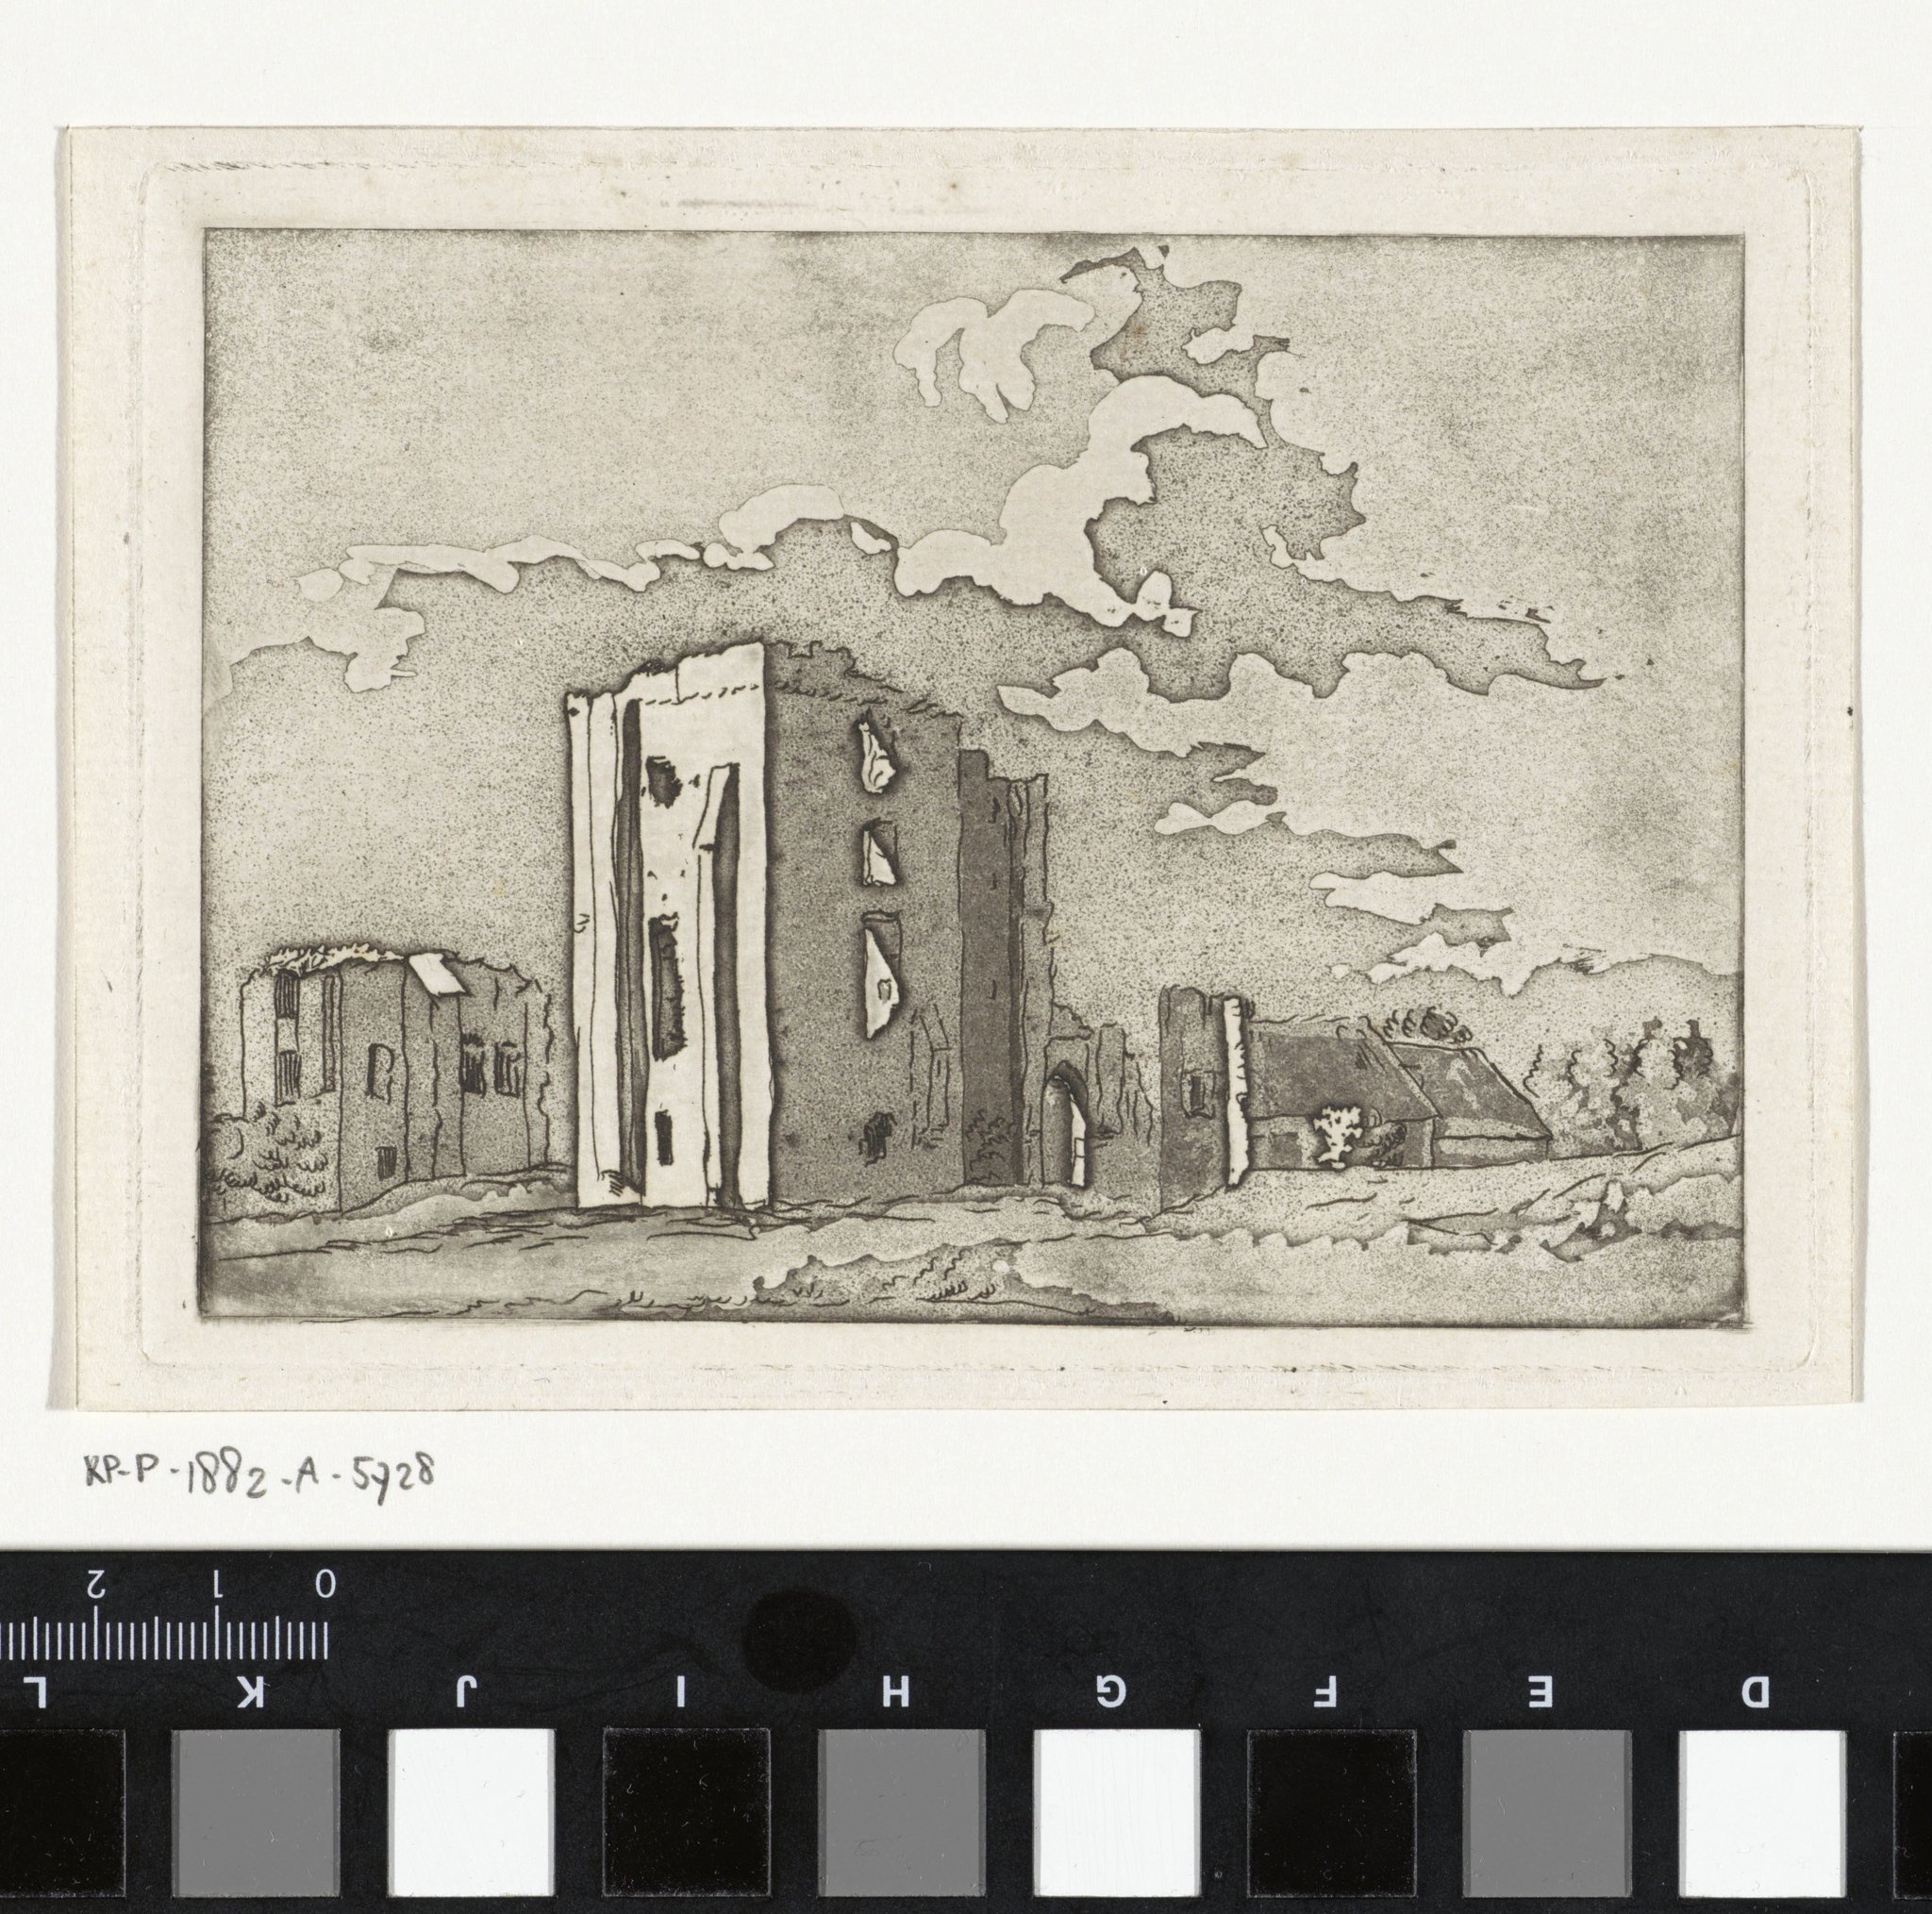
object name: print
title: Gezicht op een ruïne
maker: joannes pieter visser bender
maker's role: draughtsman, print maker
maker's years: 1785-1813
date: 1795-1813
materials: paper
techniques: aquatint, etching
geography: haarlem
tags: landscape with ruins, ruin of a dwelling, house, castle, etc.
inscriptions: collector's mark: Lugt 2228